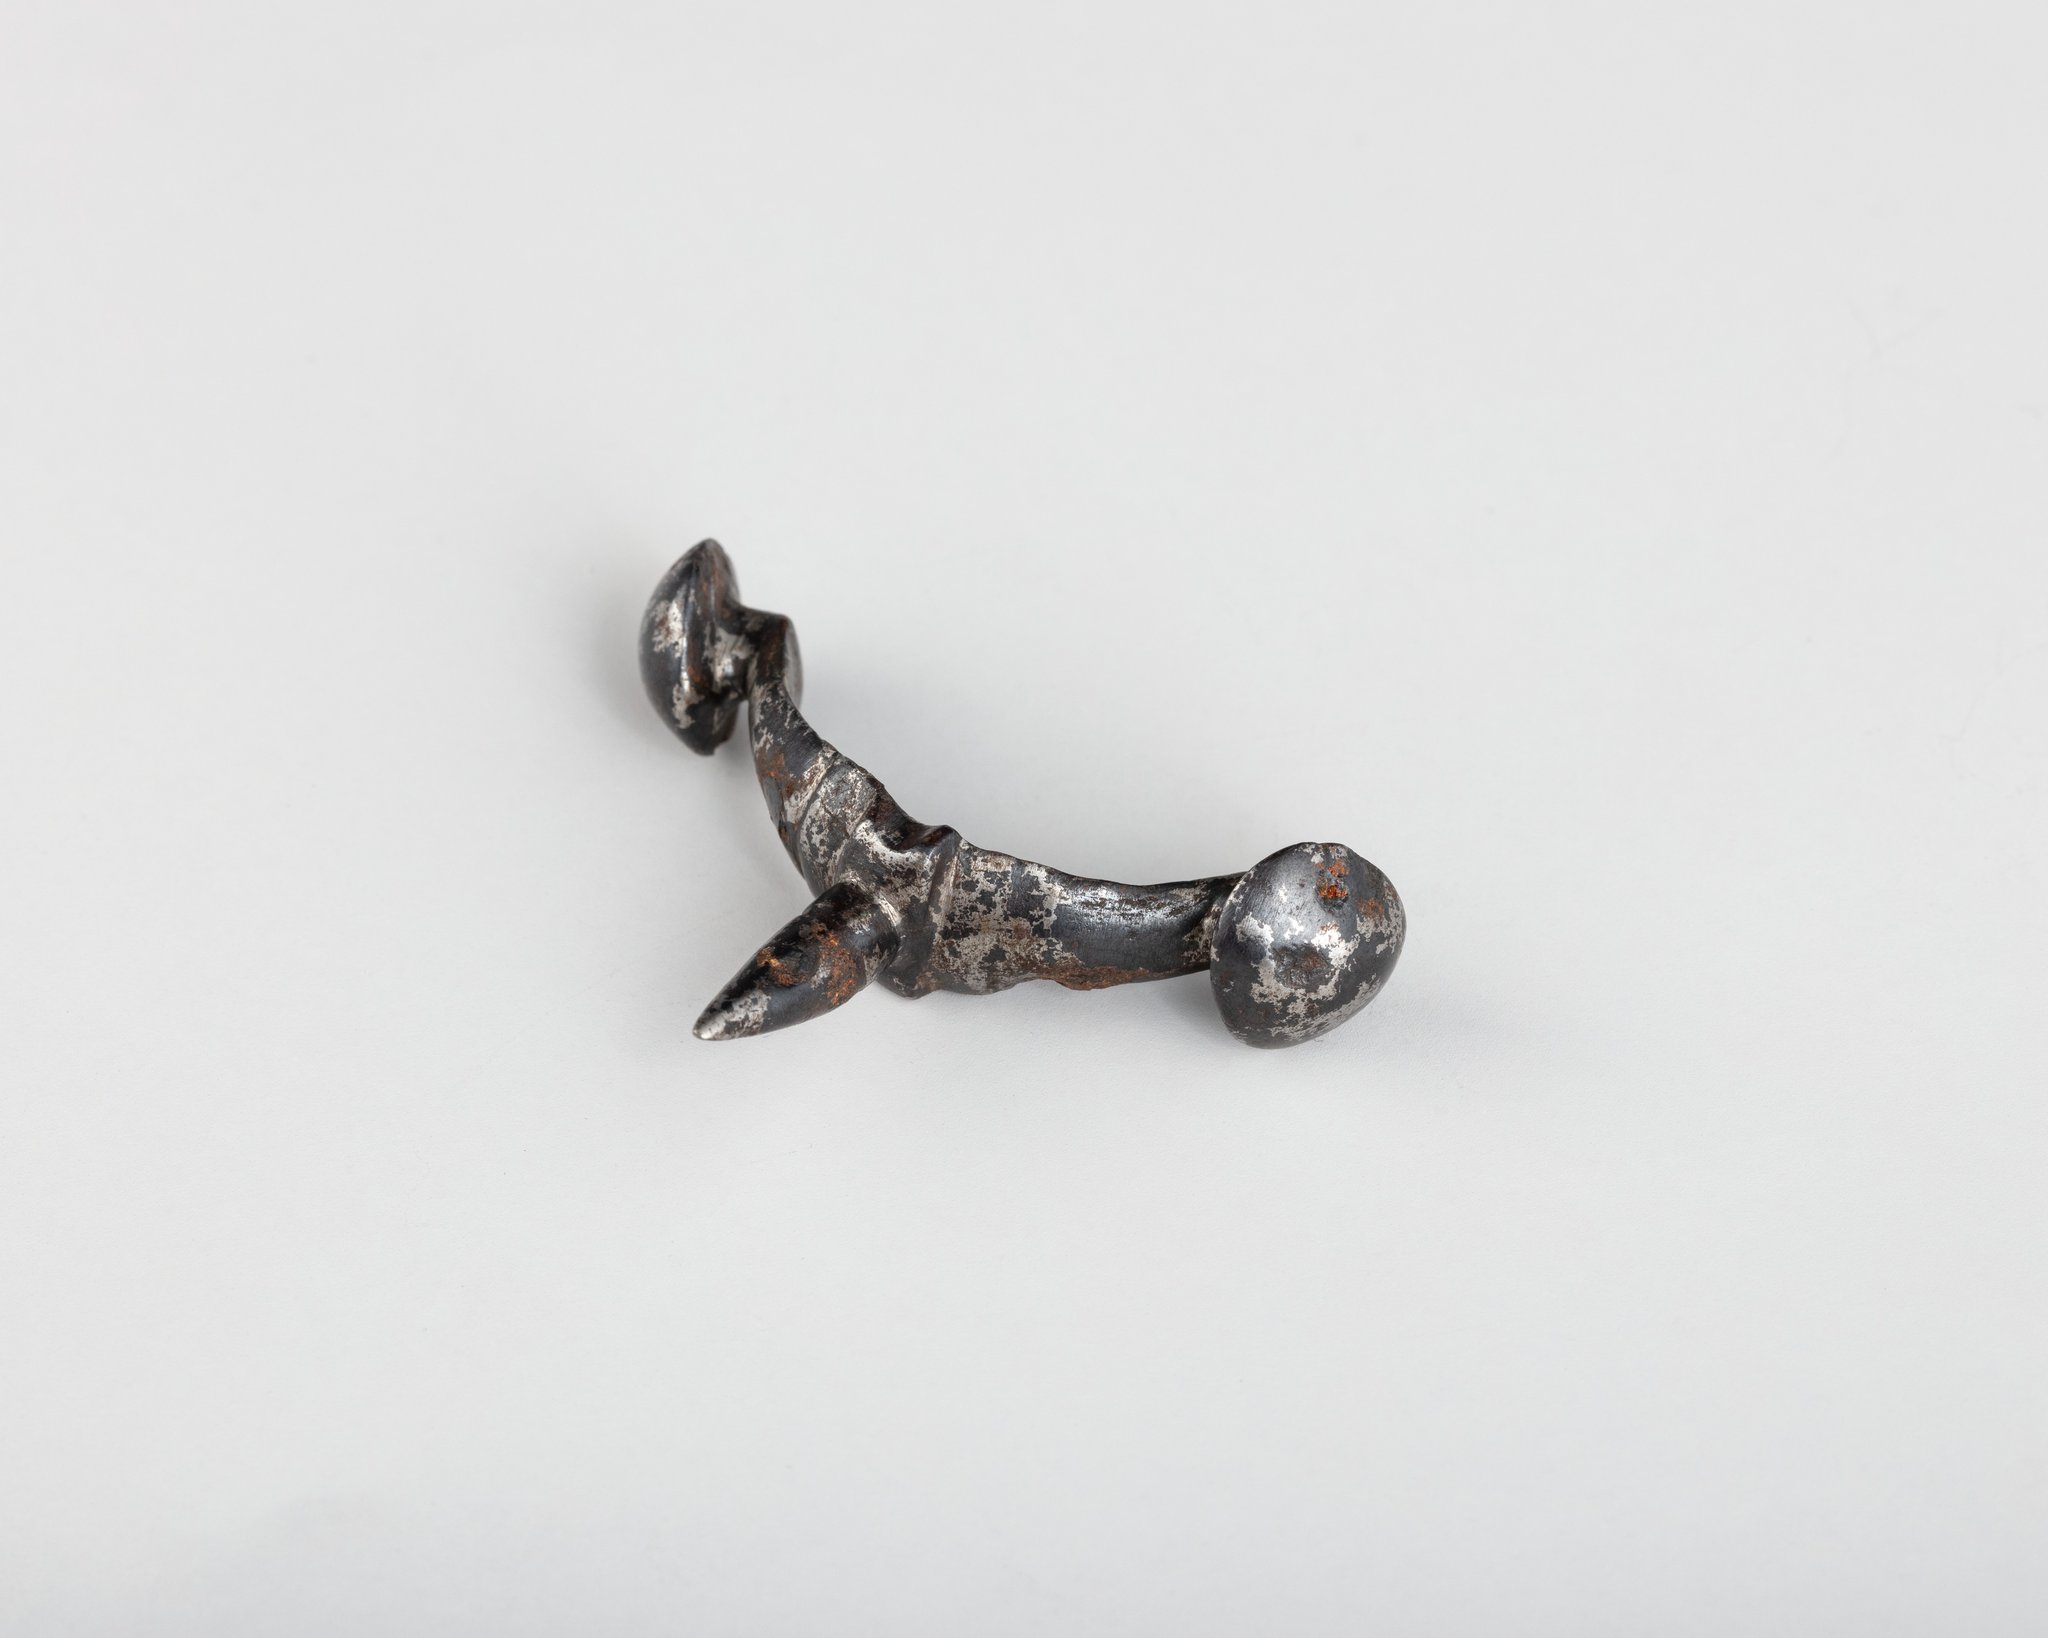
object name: spur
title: Prick Spur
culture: celtic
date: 200-1 BCE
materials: iron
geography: czech republic